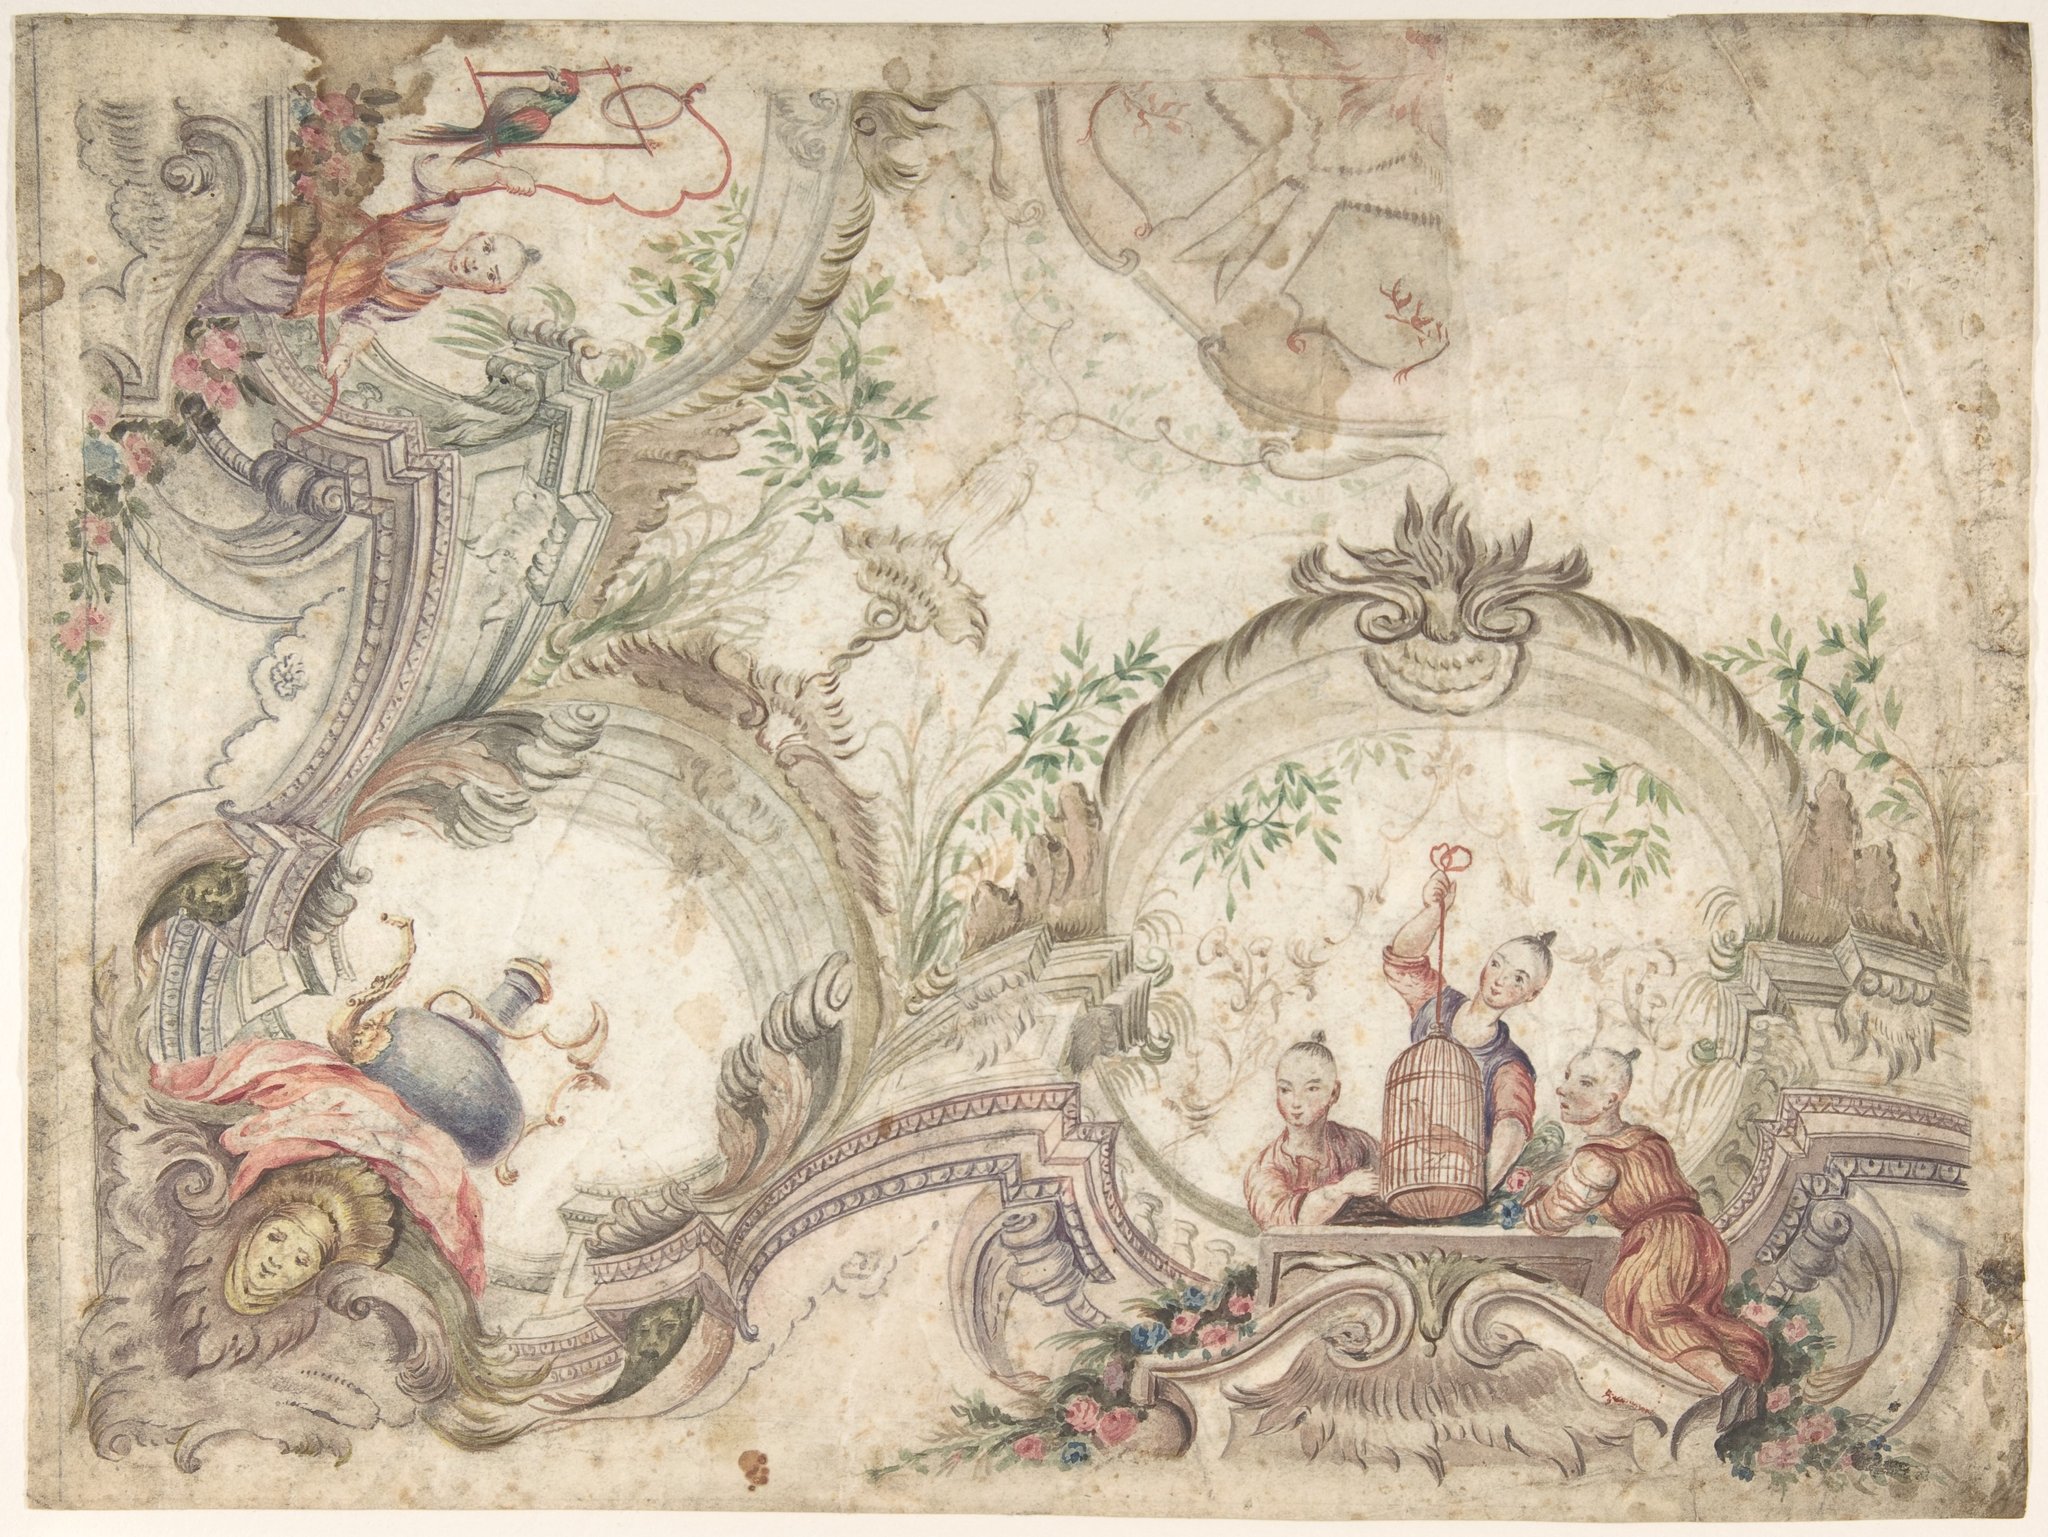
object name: drawing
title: Design for a Ceiling Decoration with Chinoiserie Scenes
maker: anonymous, italian, 18th century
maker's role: artist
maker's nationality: italian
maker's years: 1700-1800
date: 1720-1760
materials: watercolor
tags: birds,chinoiserie,ornament,men